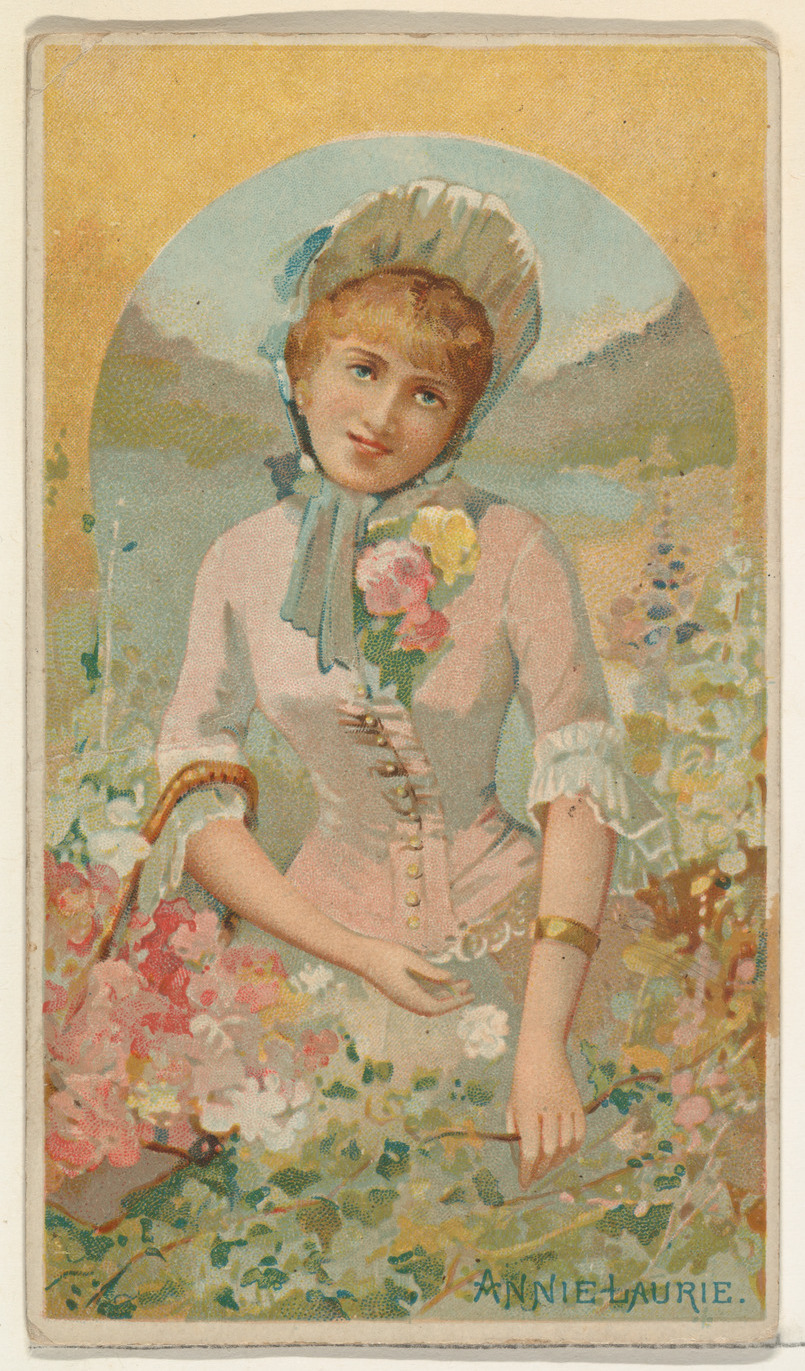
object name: print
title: Annie Laurie, from the Illustrated Songs series (N116) issued by W. Duke, Sons & Co. to promote Honest Long Cut Tobacco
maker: w. duke, sons & co.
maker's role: publisher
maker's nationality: american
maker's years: 1870-1920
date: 1893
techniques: color lithograph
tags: women